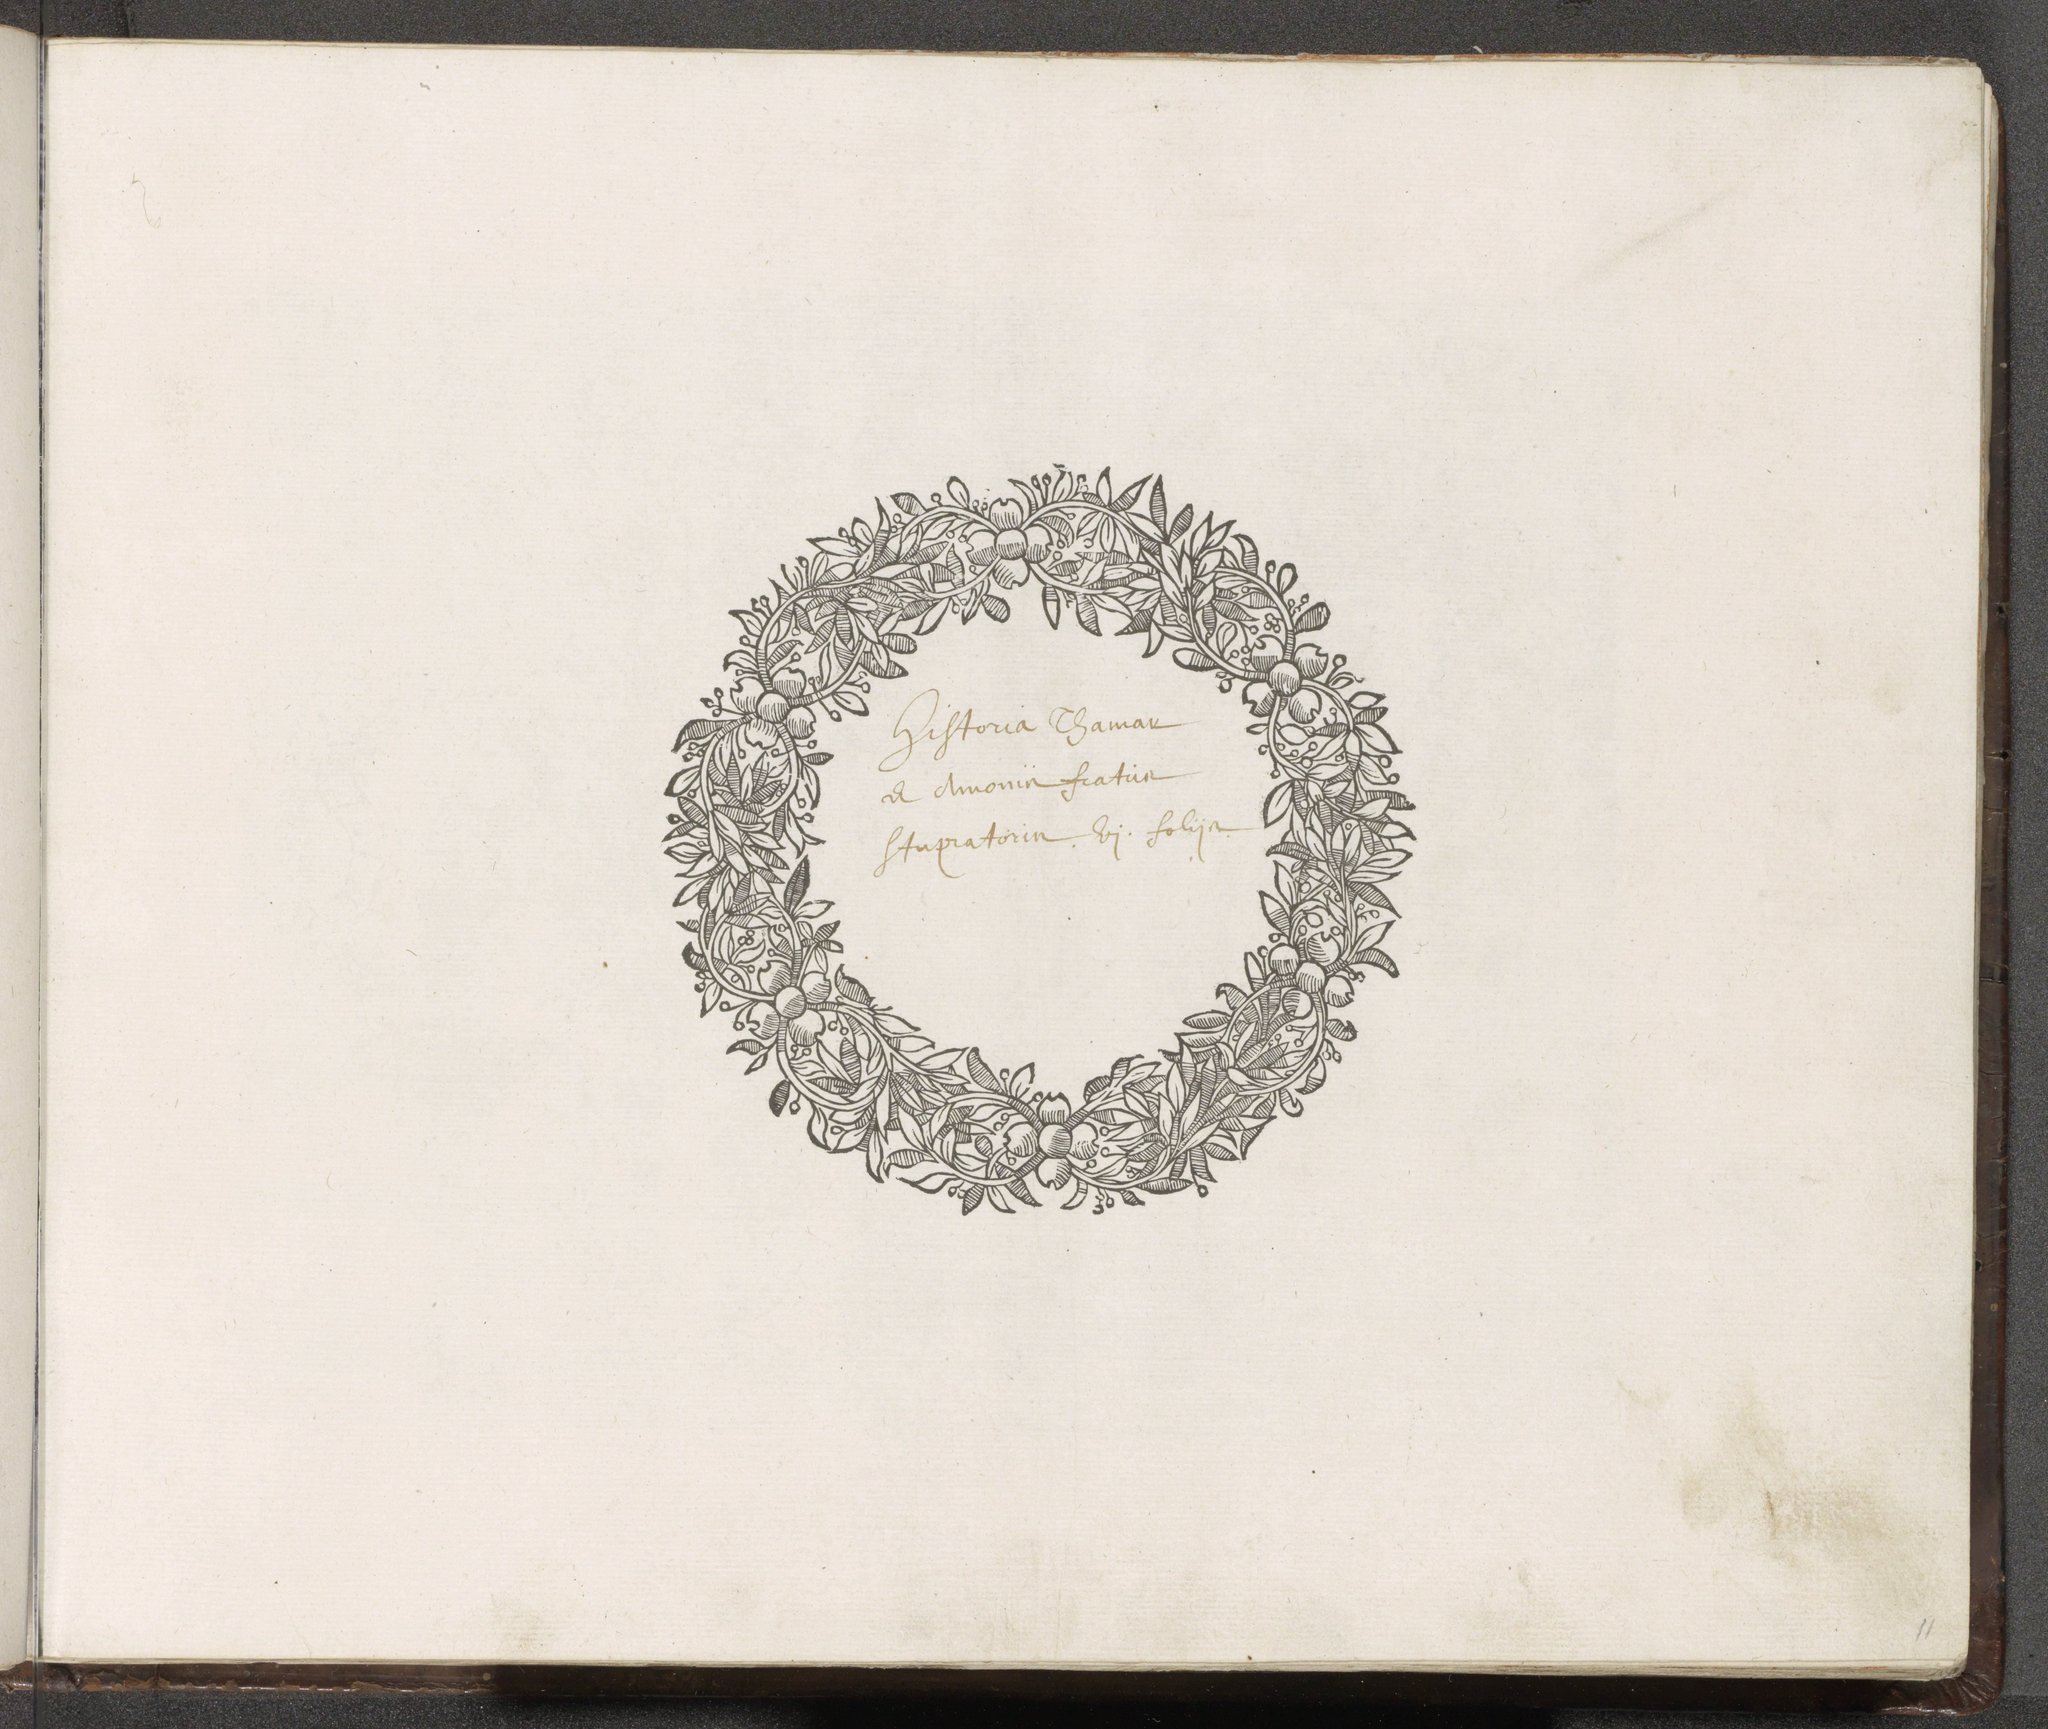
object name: album leaf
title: Ornamentele bloemenkrans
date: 1579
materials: paper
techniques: woodcut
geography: antwerp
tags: garland, wreath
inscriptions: inscription: ‘Historia Thamar et Amonia frater [...] folijn’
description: Ornamentele bloemenkrans met in het midden een handgeschreven titel. Prent maakt deel uit van een album.